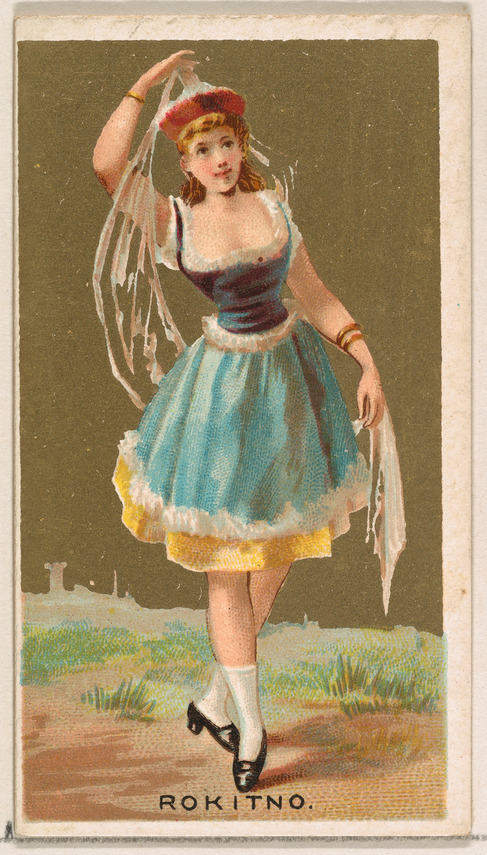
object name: print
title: Rokitno, from the Dancing Girls of the World series (N185) issued by Wm. S. Kimball & Co.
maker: william s. kimball & company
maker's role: publisher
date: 1889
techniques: color lithograph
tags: women